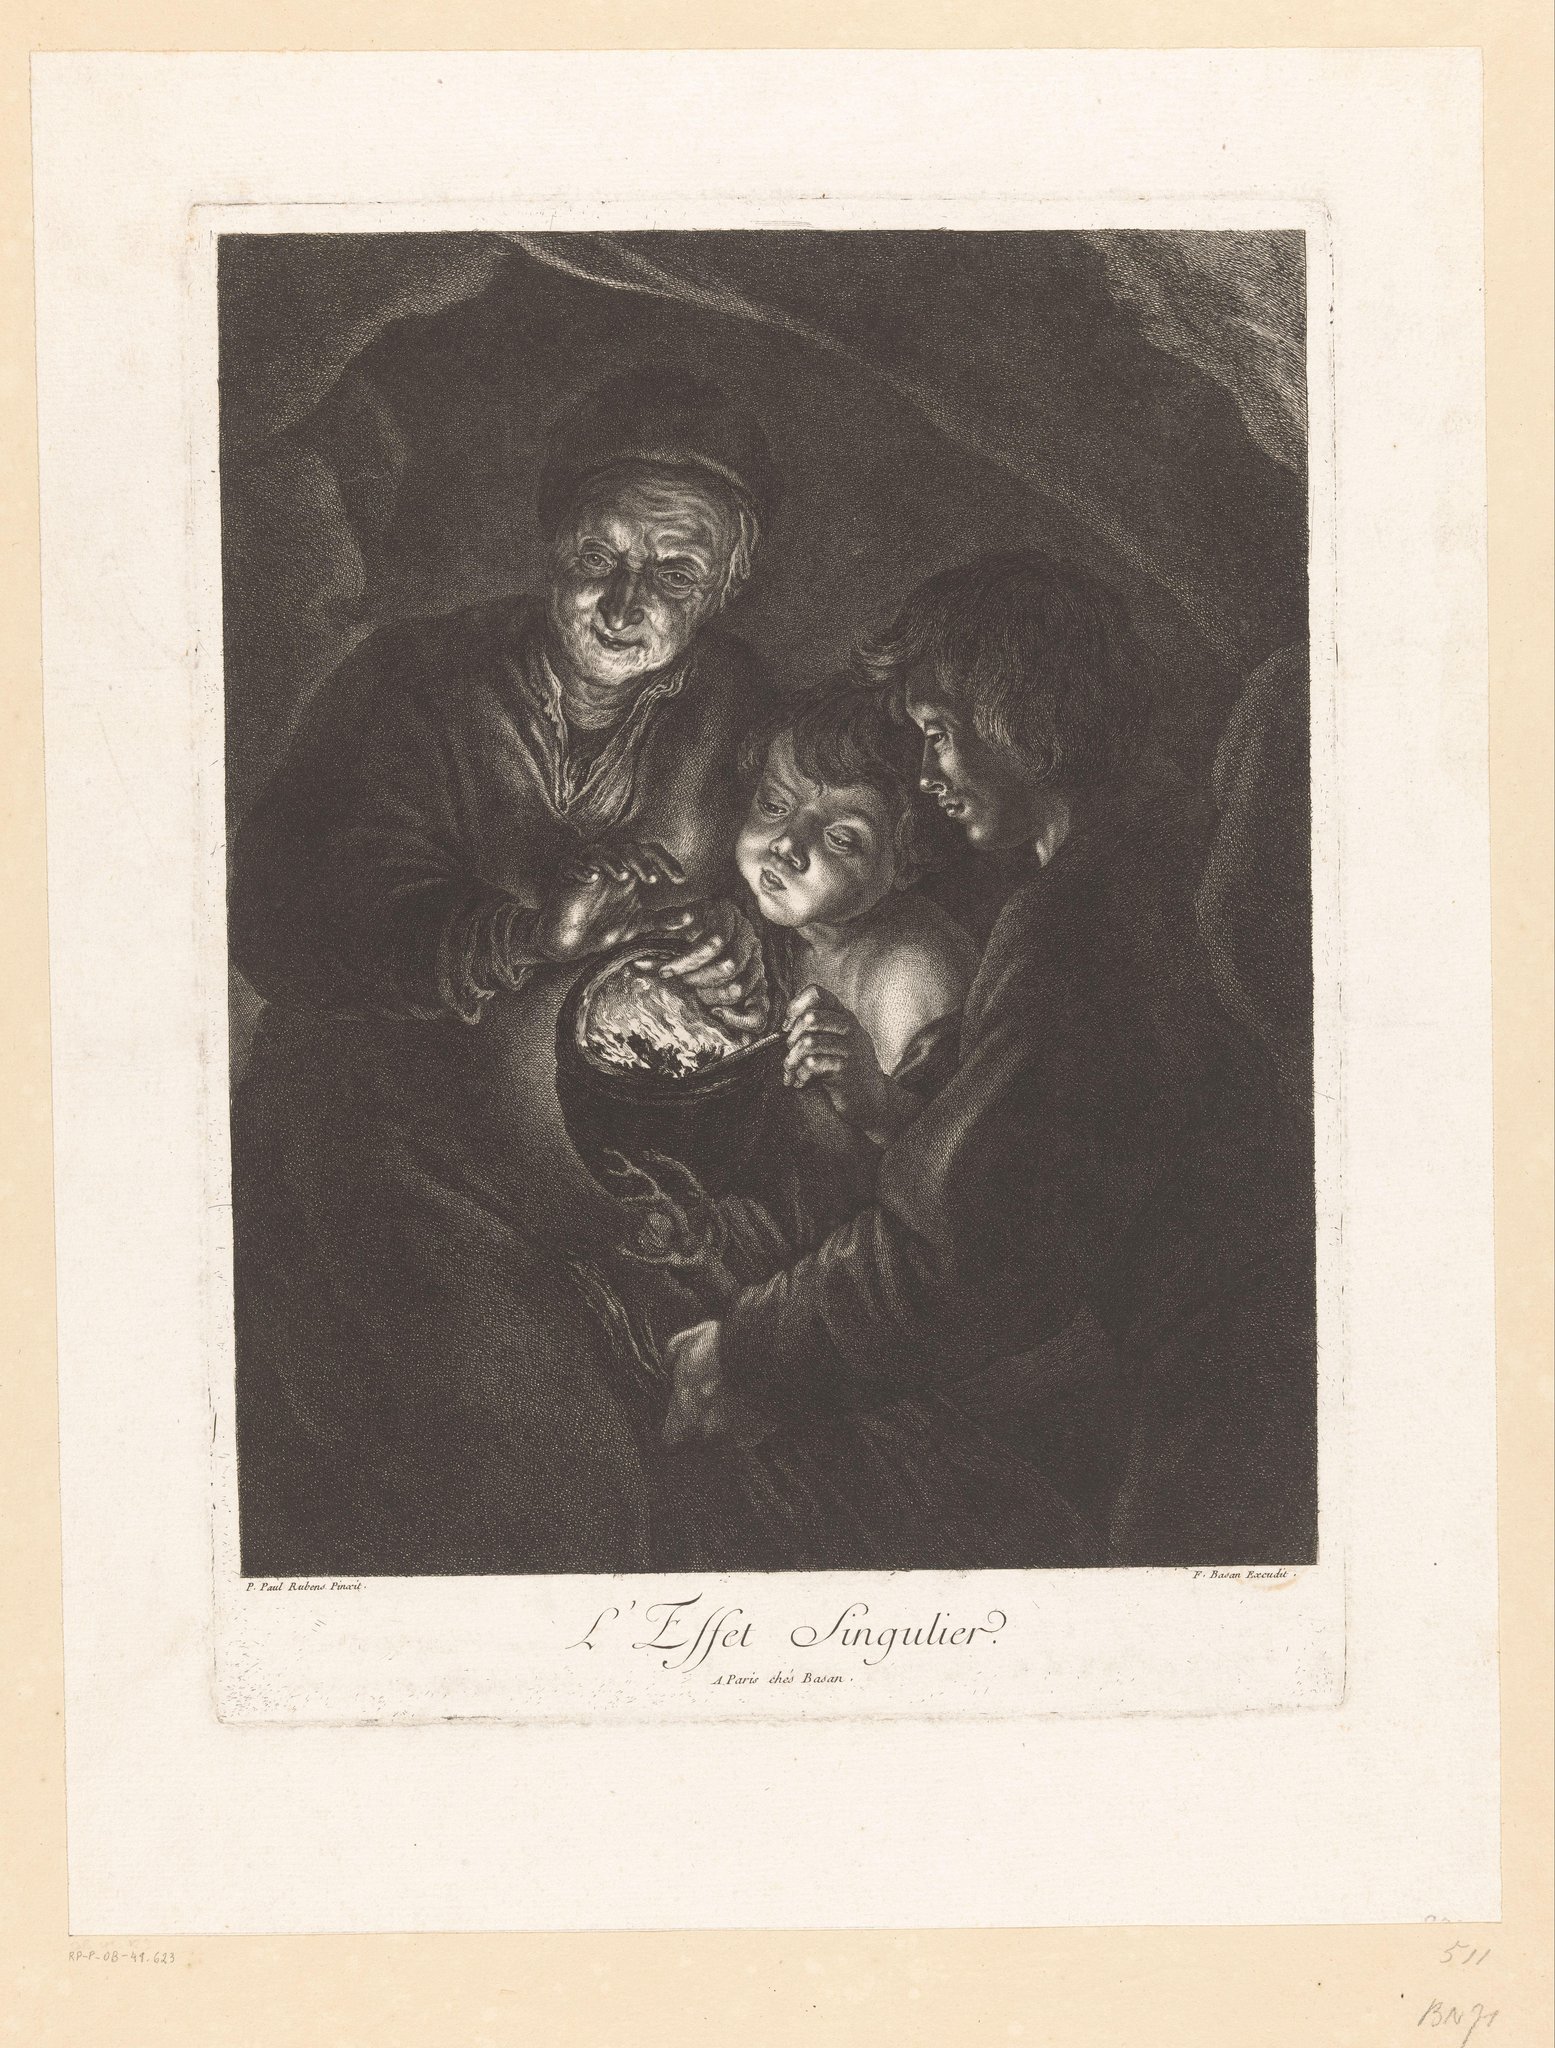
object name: print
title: L'effet singulier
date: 1733-1797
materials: paper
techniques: engraving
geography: paris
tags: blowing (stirring up a fire), boy (child between toddler and youth), old woman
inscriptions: collector's mark: Lugt 240